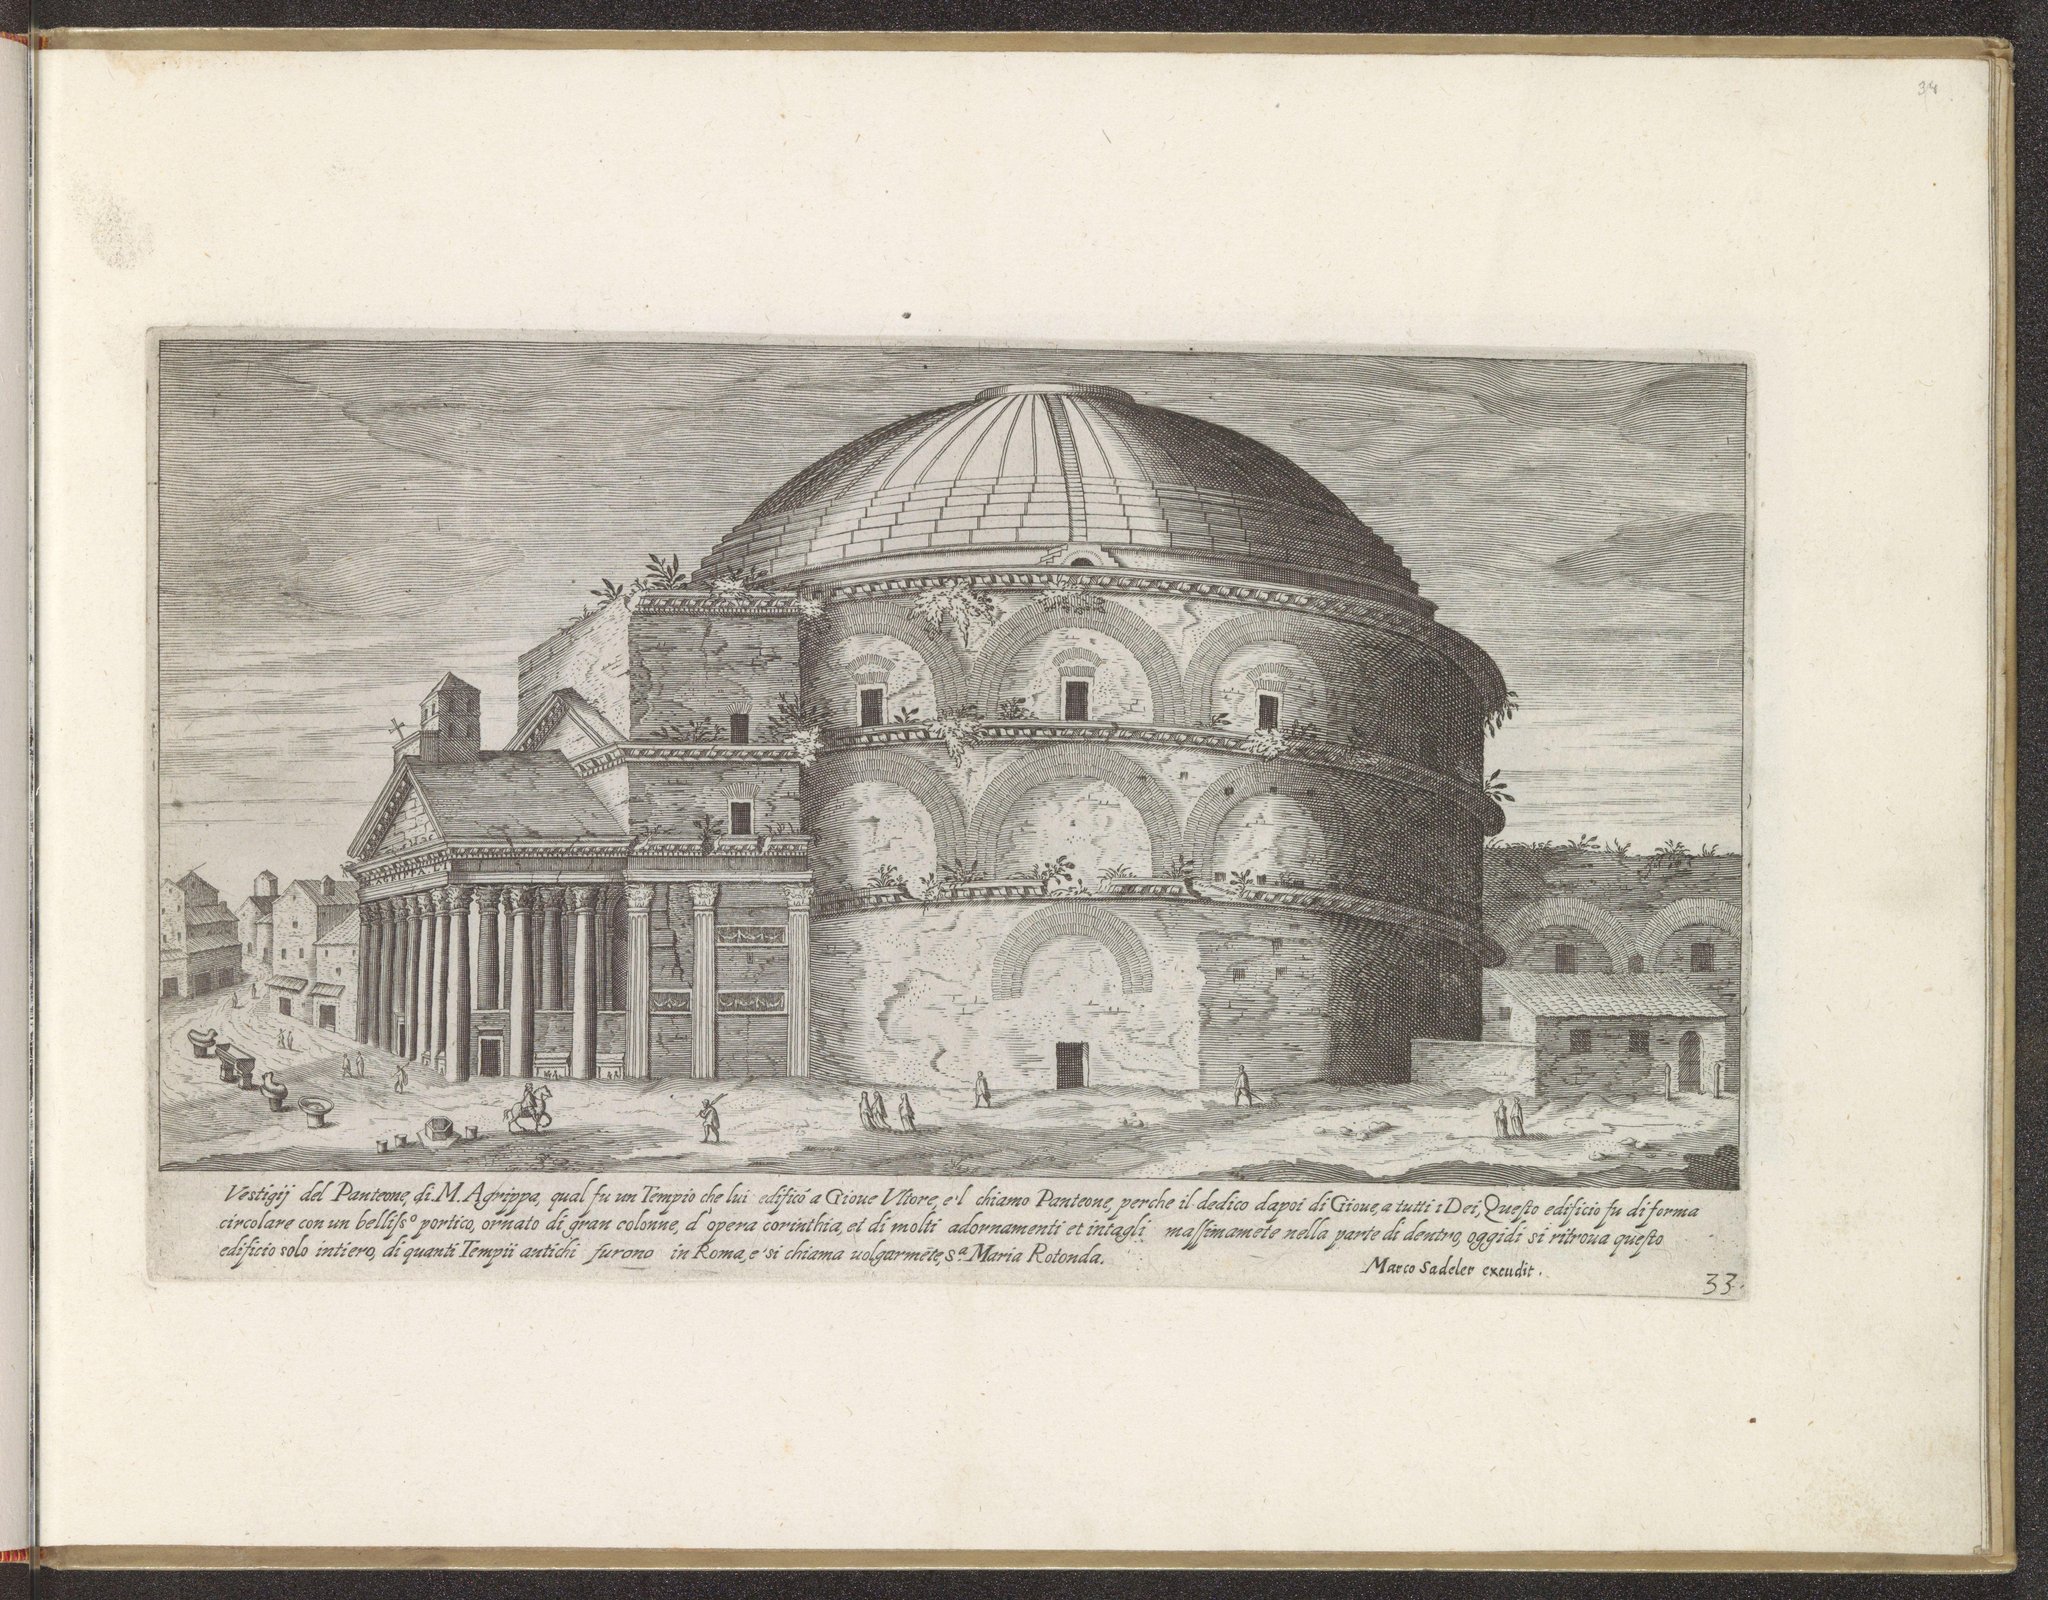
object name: print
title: Pantheon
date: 1606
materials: paper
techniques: engraving, etching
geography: prague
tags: rome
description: Kopie naar de prent van Etienne Dupérac in: I Vestigi dell' antichità di Roma raccolti et ritratti in perspettiva, 1575.